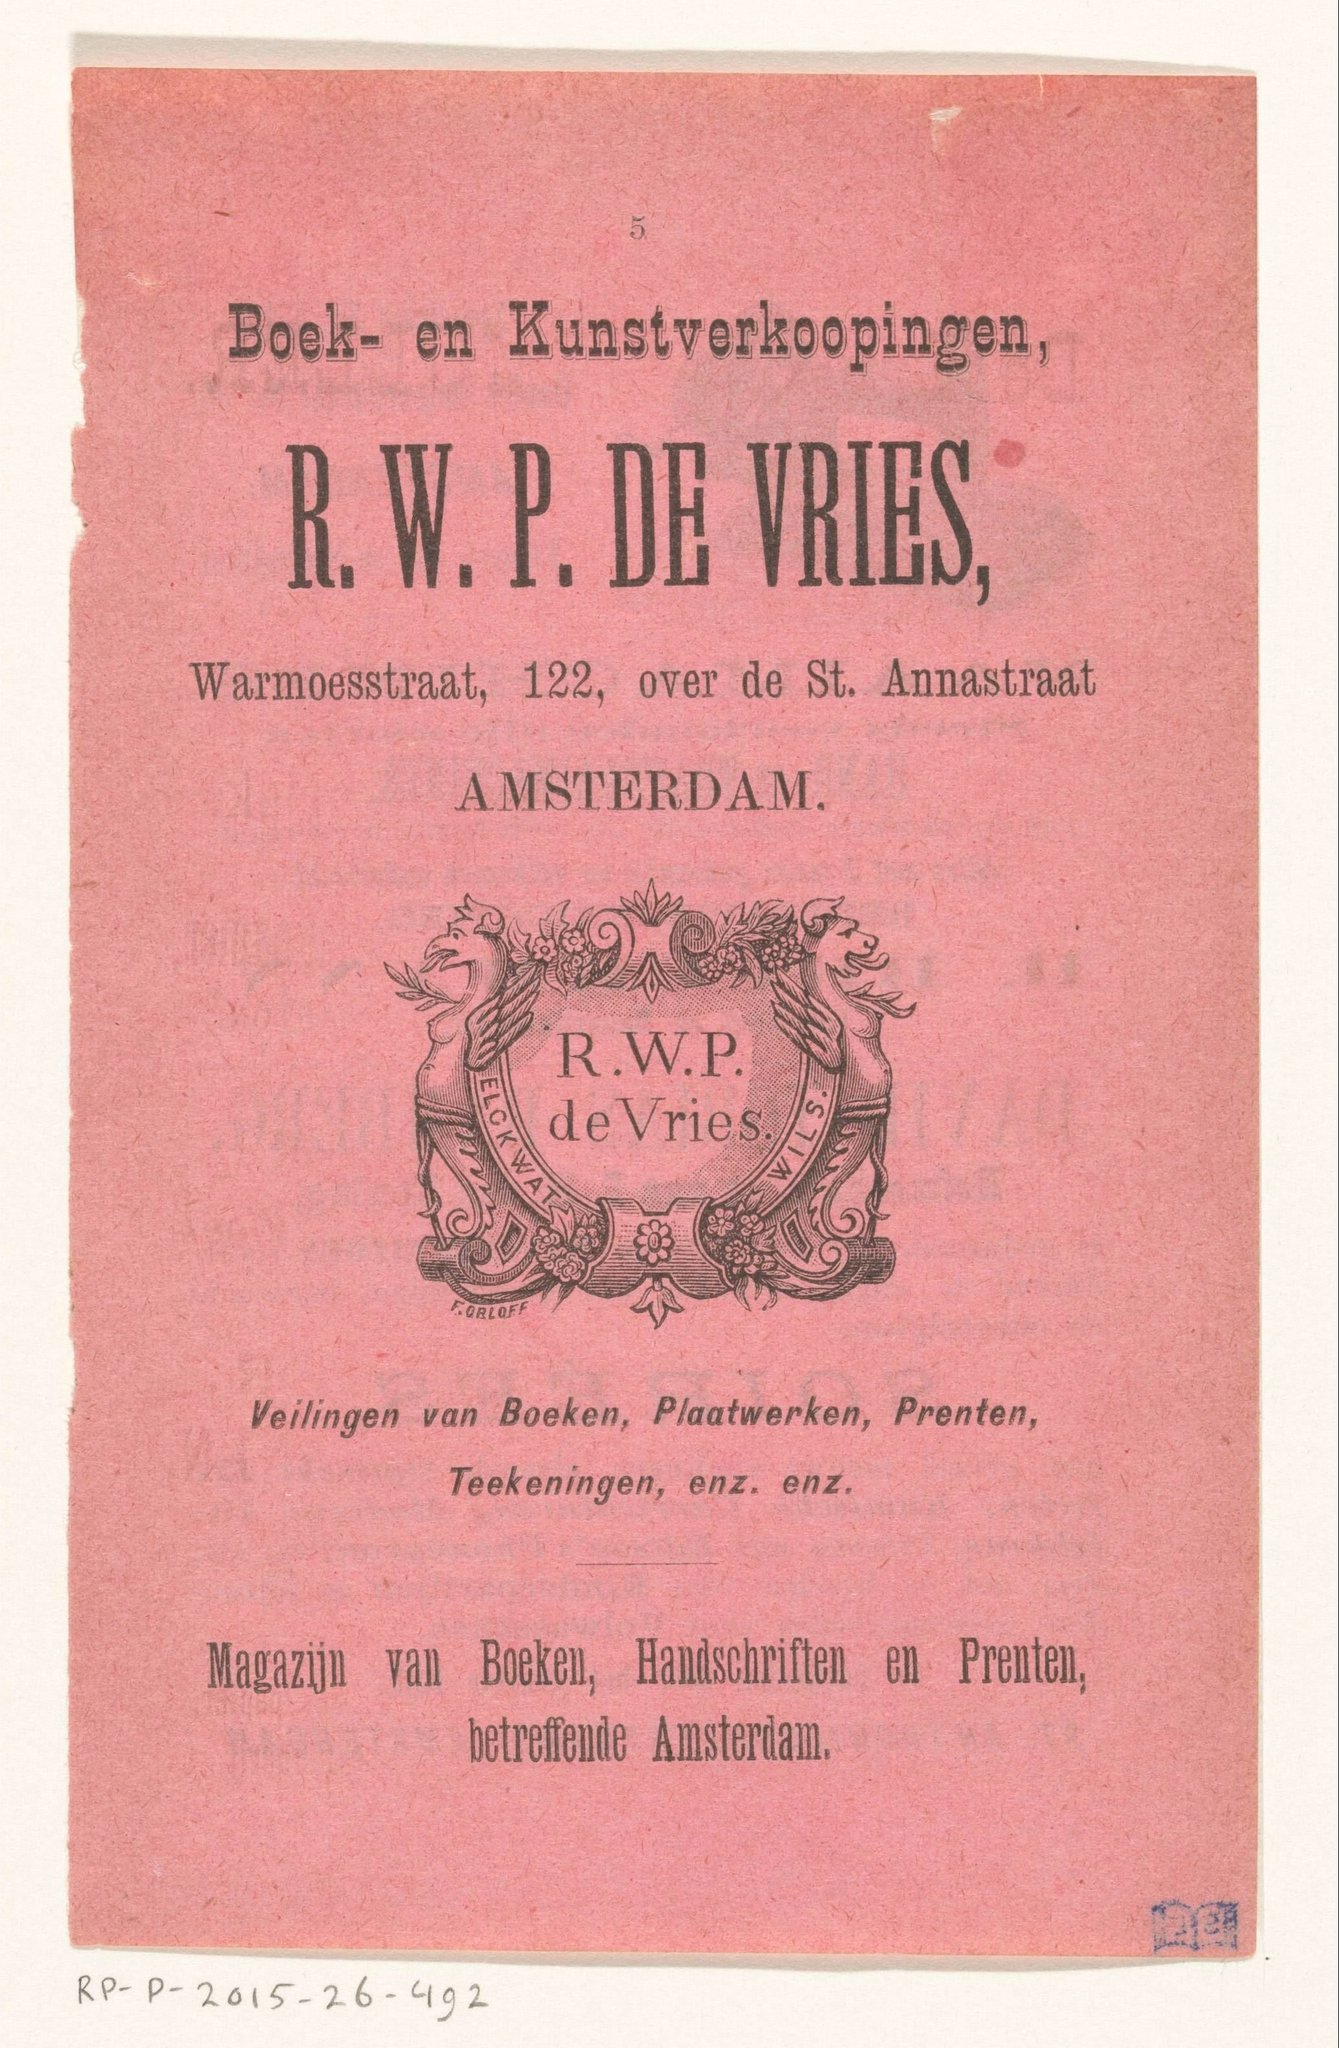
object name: print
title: Advertentie voor veilinghuis en boekhandel R.W.P. de Vries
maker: frits orloff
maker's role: print maker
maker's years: 1837-1883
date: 1876-1885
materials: paper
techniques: letterpress printing, engraving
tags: device (trade-mark of printer or publisher)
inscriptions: collector's mark: Lugt 4780, collector's mark: Lugt 2228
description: Op verso advertenties voor naaimachines van H. Brückmann en Soirée met optredens van David Tobias Bamberg.